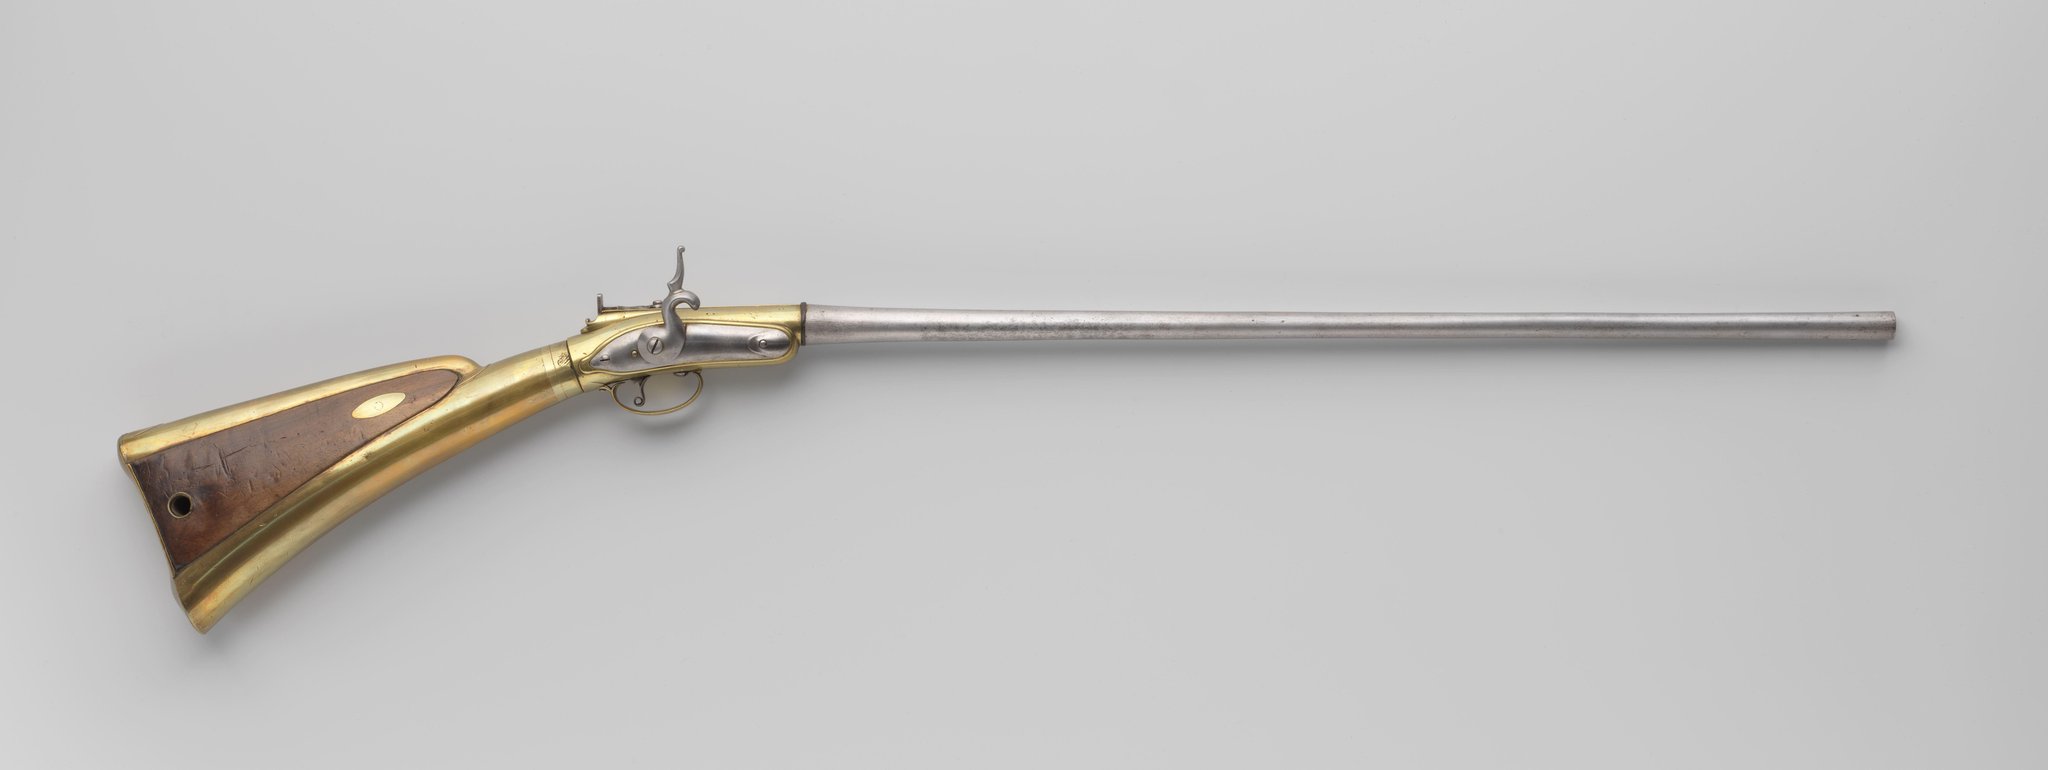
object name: musketon, karabijn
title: Luchtdrukkarabijn met luchtpomp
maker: johan leur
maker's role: geweermaker, pistoolmaker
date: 1710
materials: brass, copper, iron, wood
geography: rotterdam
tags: netherlands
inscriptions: : ‘I. Leur Rotterdam’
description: Windbuks met sleutel omstreeks 1700. Geen vizierkorrel, wel een ijzeren keep op de messing slotplaat, met de naam `I. Leur, Rotterdam'. Rond slot, holle koperen kolf, gedeeltelijk met hout bekleed. Loop en kolf kunnen worden afgedraaid. Haan defect. Wisstok met sleutel niet bijbehorend.